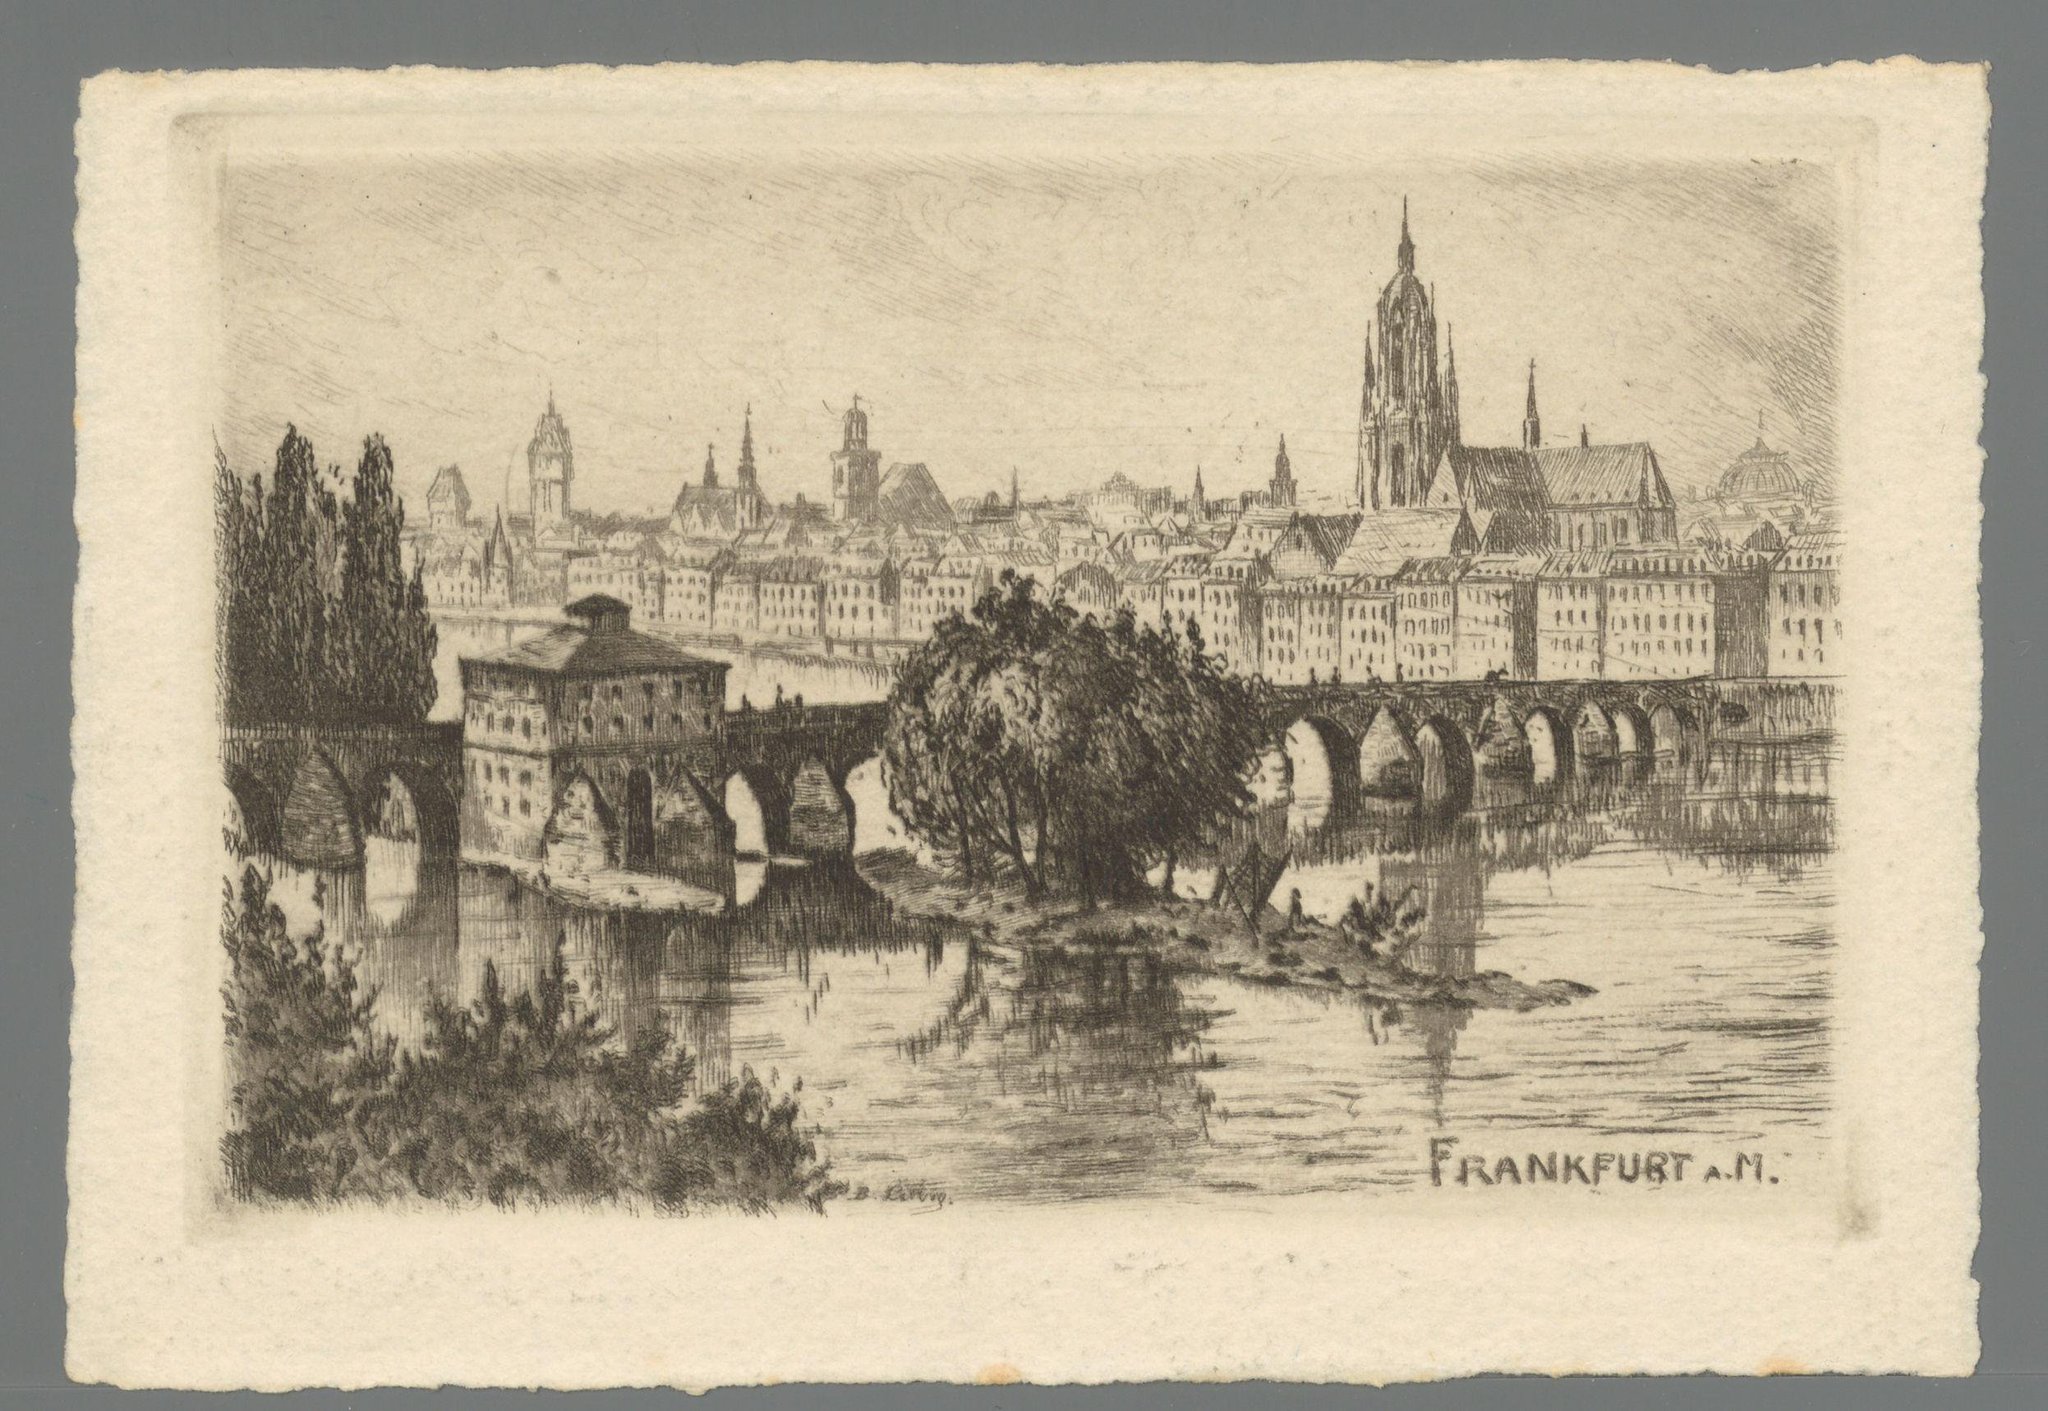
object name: ansichtkaart, prentbriefkaart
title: Frankfurt a. M.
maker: georg bernhard liebig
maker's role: painter, print maker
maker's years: 1873-1937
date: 1905-1930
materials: cardboard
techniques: etching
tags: city-view, and landscape with man-made constructions, church (exterior), canals, waters (in city), watermill, bridge in city across river, canal, etc.